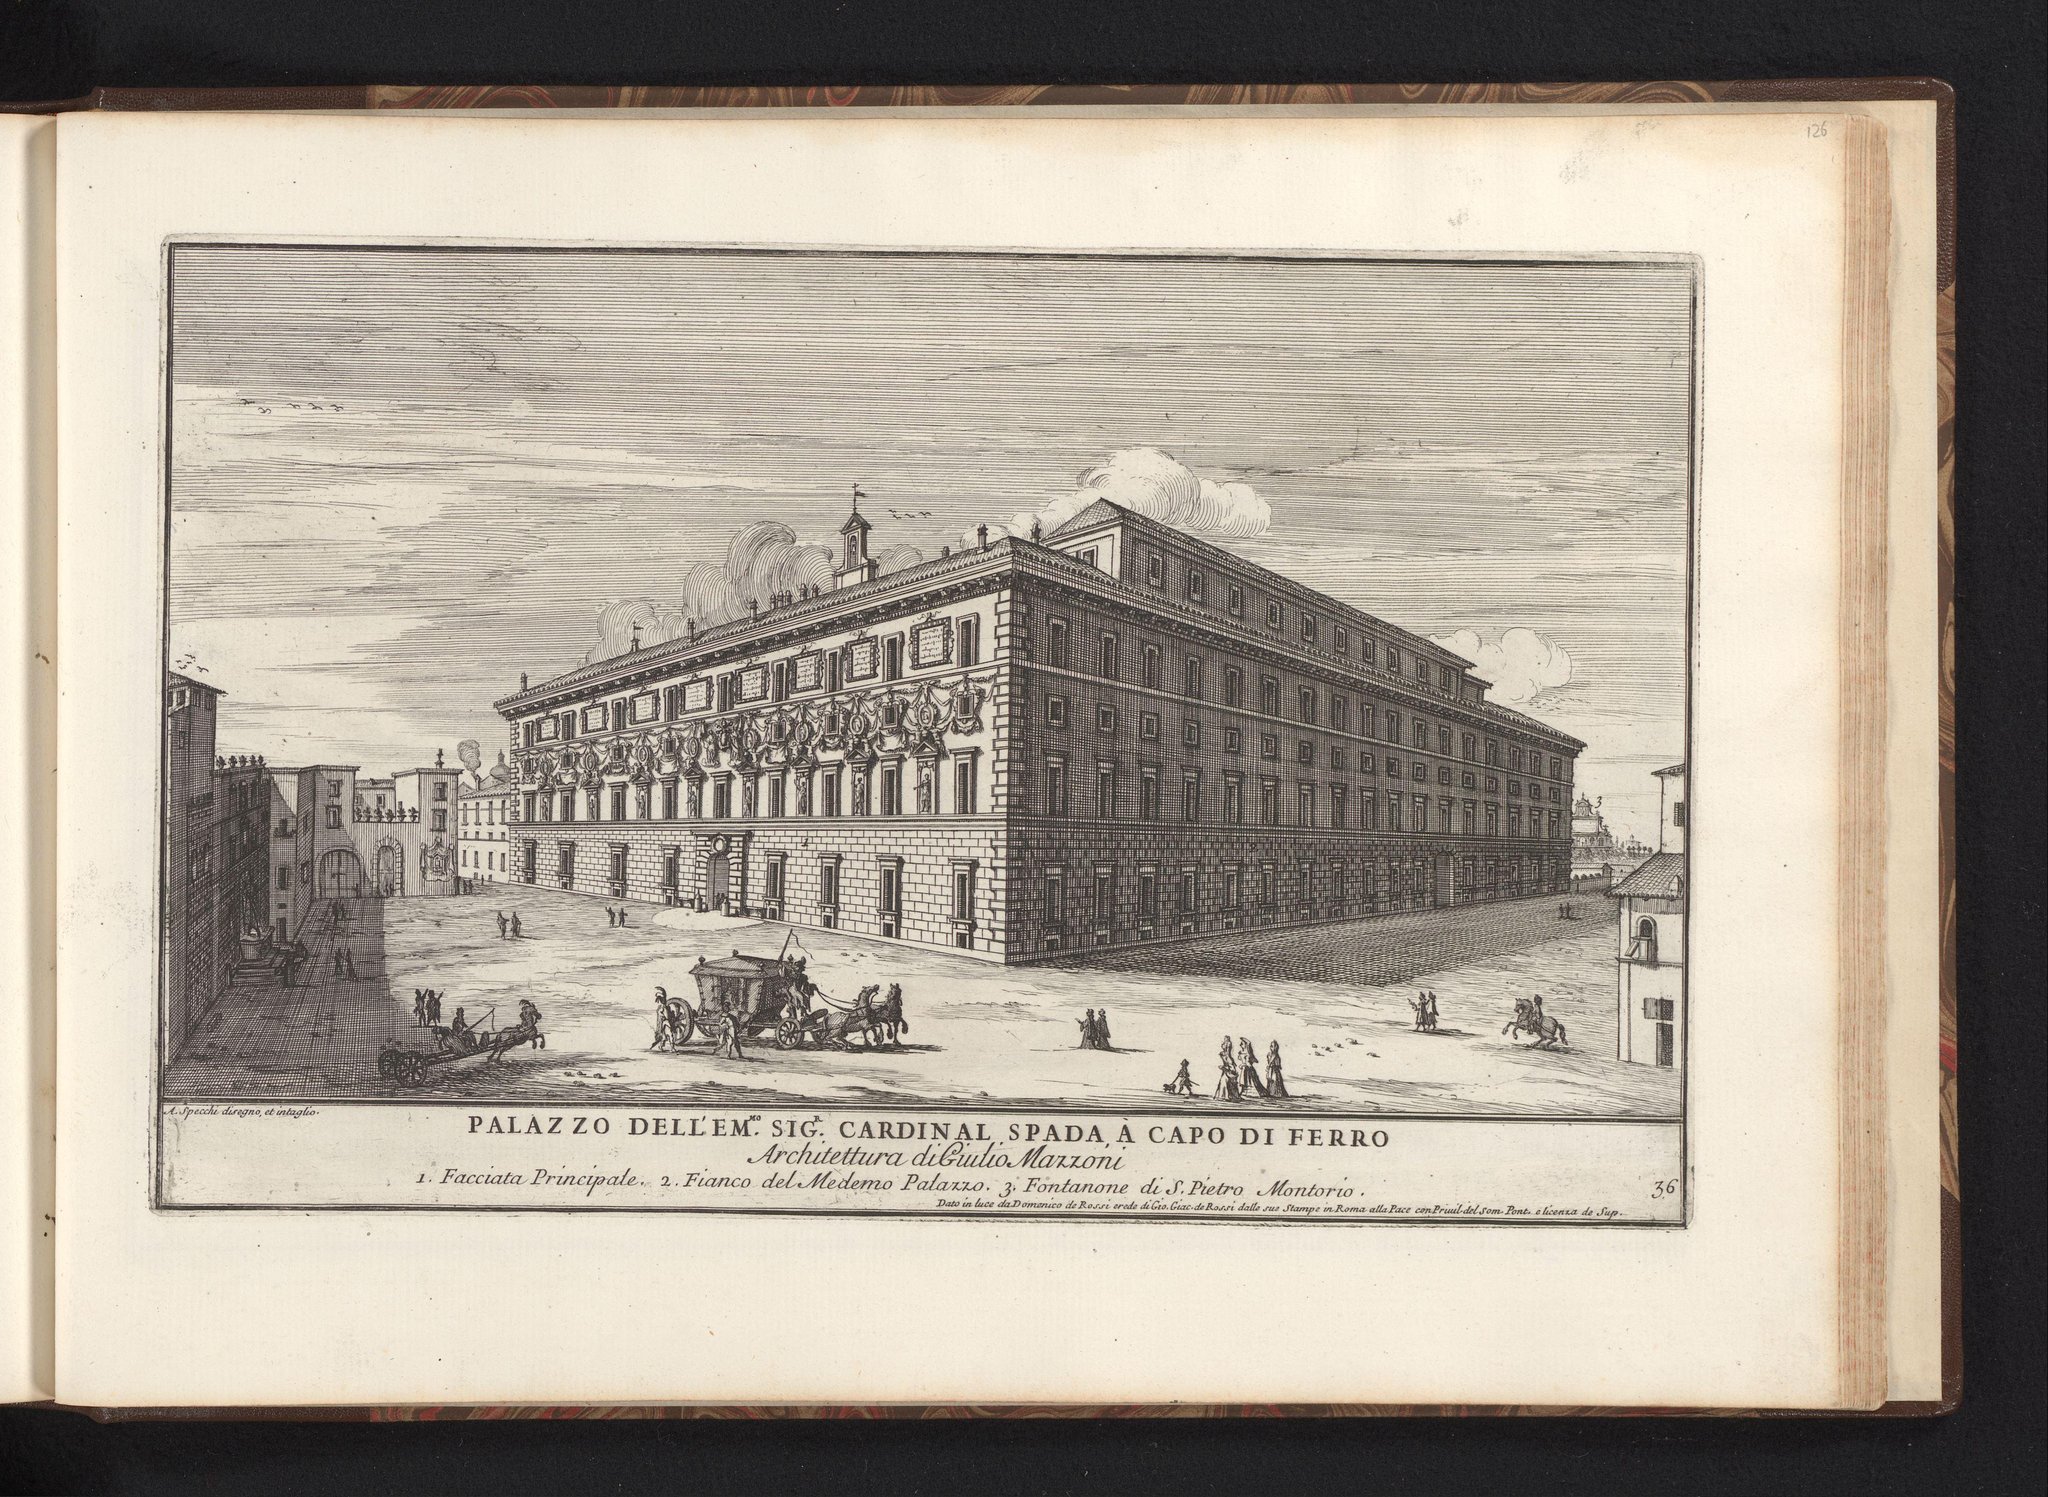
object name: print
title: Moderne gebouwen te Rome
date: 1699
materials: paper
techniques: etching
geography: italy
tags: city-view, and landscape with man-made constructions, hôtel, i.e. small palace in city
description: Deze prent maakt deel uit van een reeks van 52 prenten met voorstellingen van paleizen in Rome. Samen met vier andere reeksen vormt het de grote reeks: 'Il nuovo teatro di Roma moderna'.